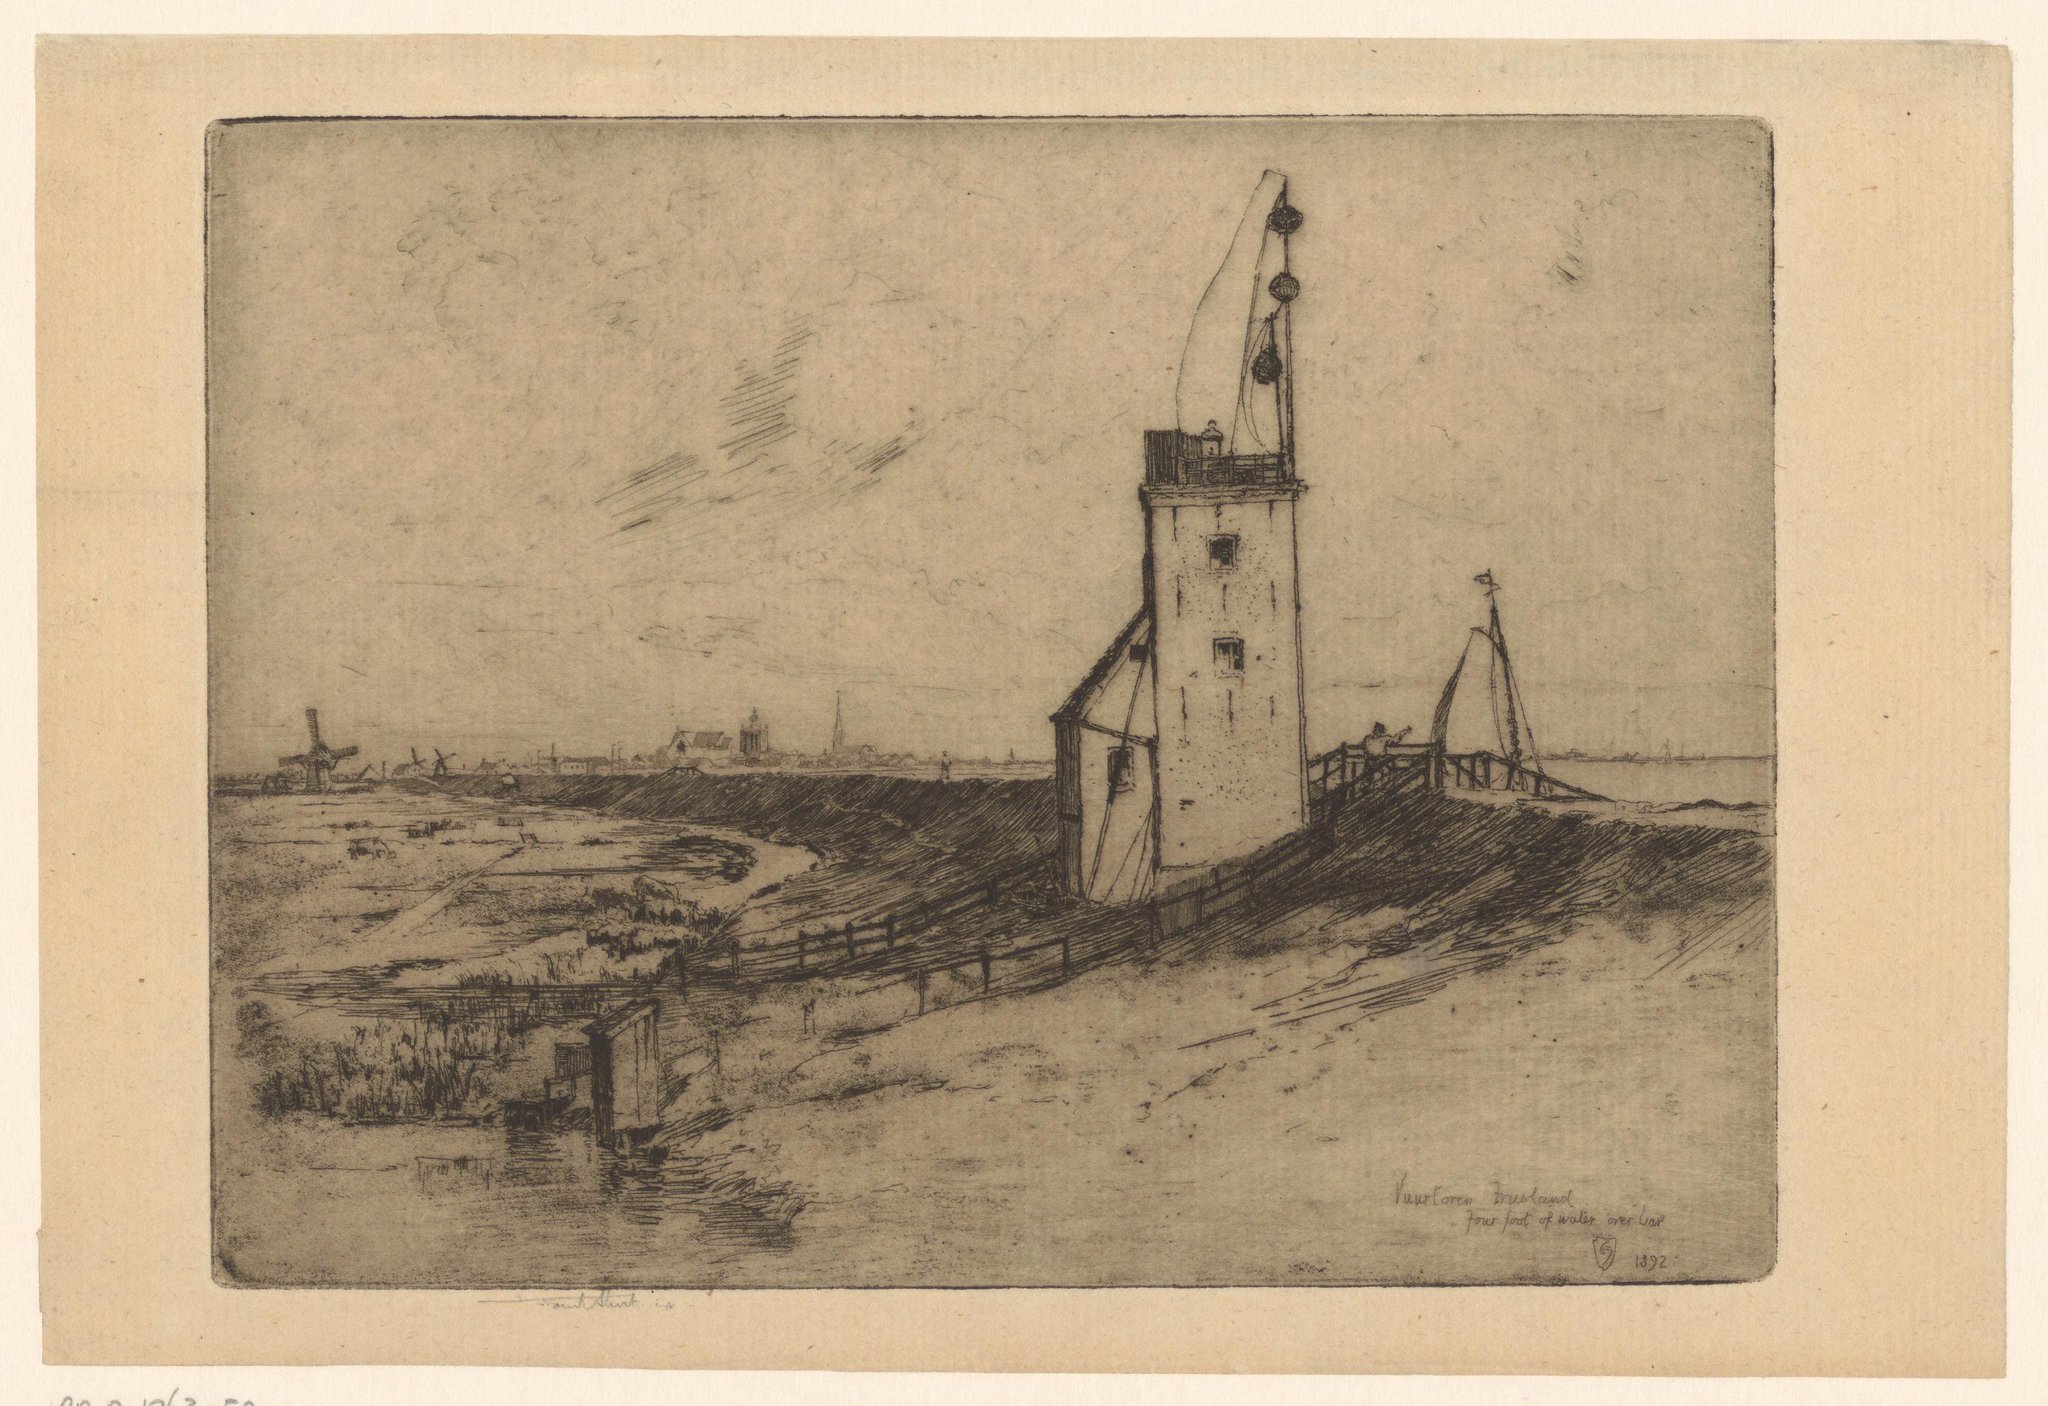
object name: print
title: Vuurtoren Friesland four feet of water over bar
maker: frank short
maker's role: print maker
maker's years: 1857-1945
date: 1892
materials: paper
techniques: etching, intaglio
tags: lighthouse, lightship, windmill in landscape, dikes, levee, coast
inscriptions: collector's mark: Lugt 2760, collector's mark: Lugt 2228, signature: ‘Frank Short’